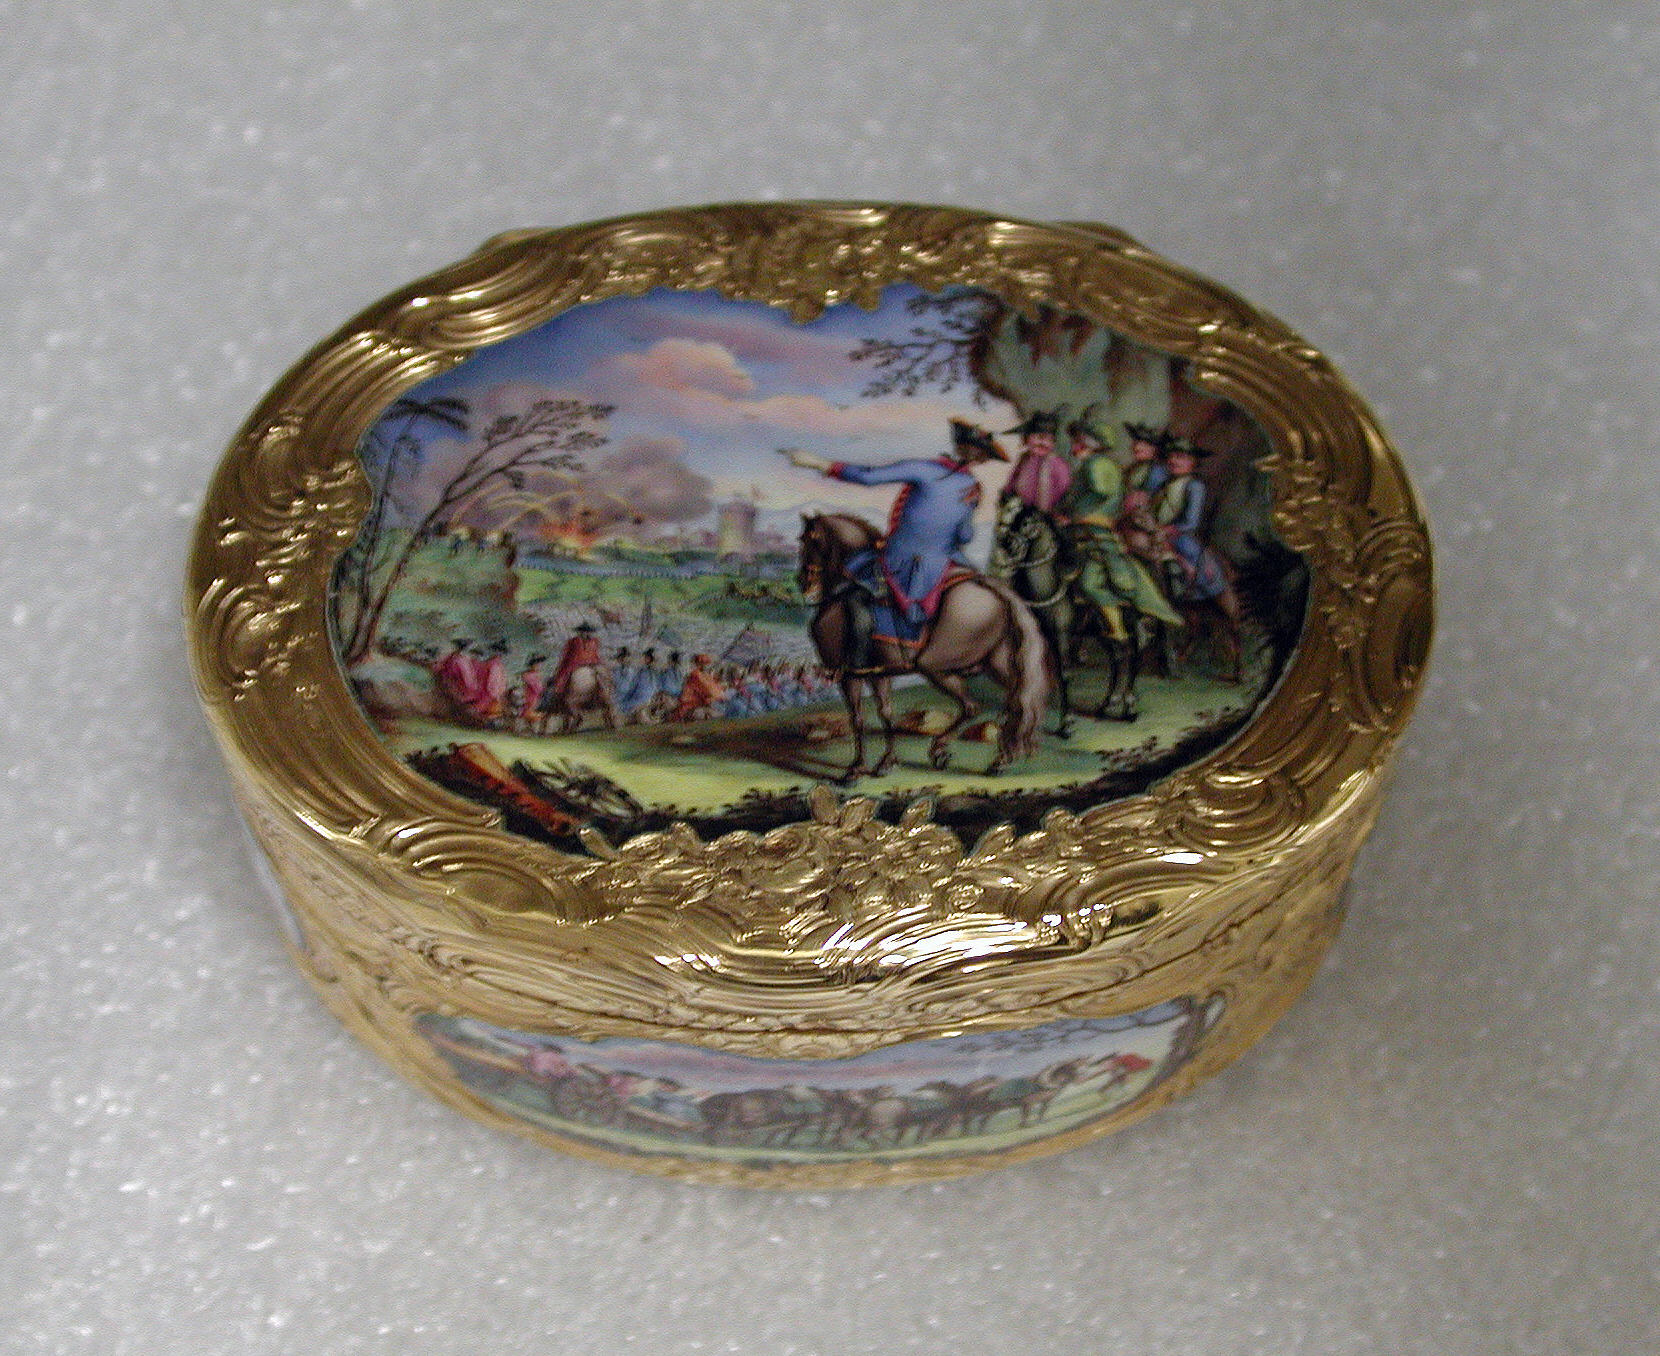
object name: snuffbox, painting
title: Snuffbox with military scenes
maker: i.i.h.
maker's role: maker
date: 1770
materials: enamel, gold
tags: men,horses,flowers